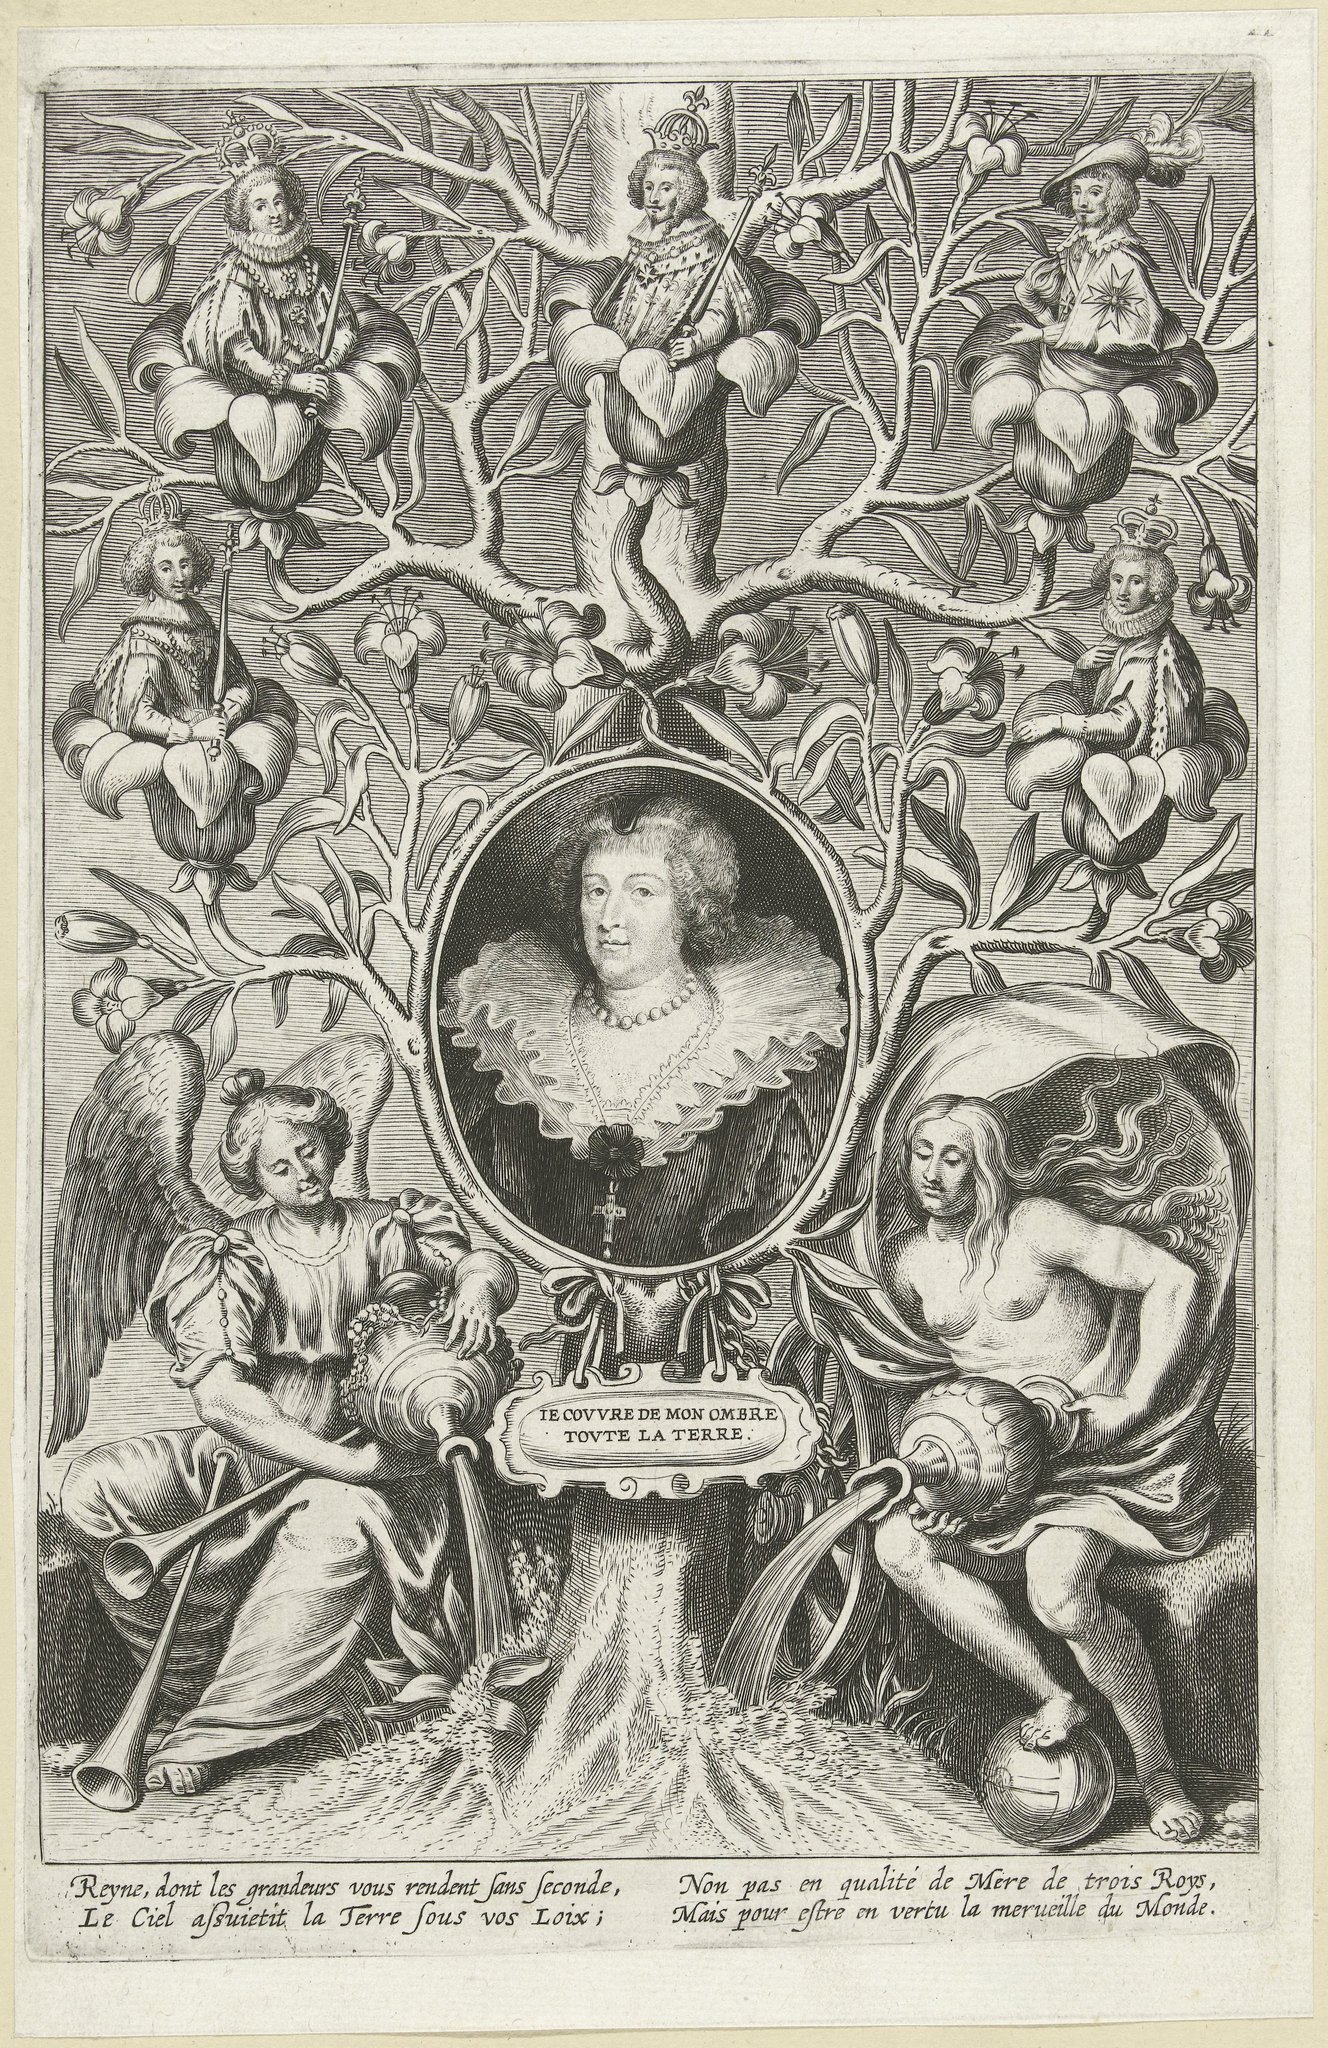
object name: print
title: Stamboom van Maria de Medici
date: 1610-1678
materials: paper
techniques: engraving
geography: antwerp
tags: maria de' medici, family lineage, pedigree, genealogical tree or table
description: Stamboom met in het midden een ovaal portret van Maria de Medici. Een engel en een Venus wateren de boom uit kruiken. In de bloemen van de boom zitten Marias familieleden. Onder de voorstelling een Franse tekst.